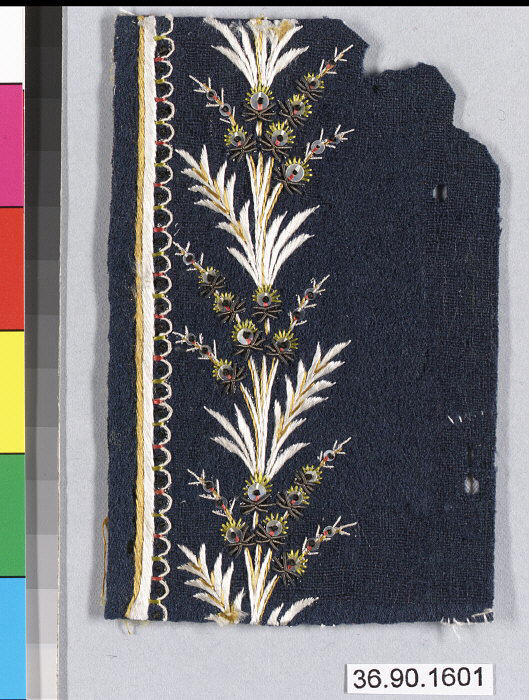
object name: sample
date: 1801-1833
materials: felt, metal thread, silk